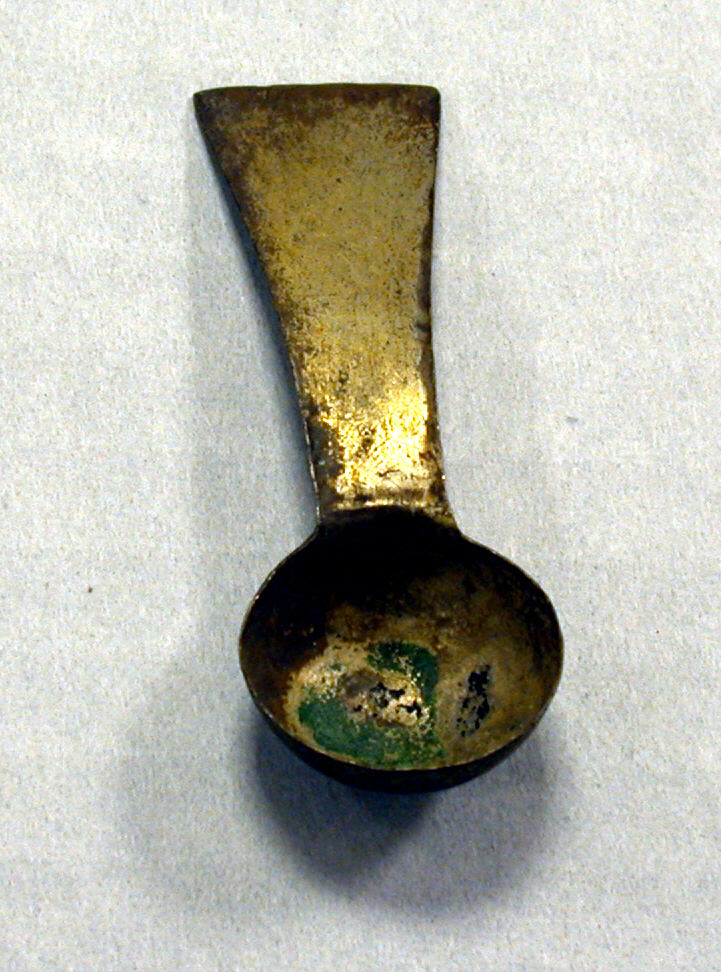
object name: spoon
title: Hammered Silver Spoon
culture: peruvian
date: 701-1566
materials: gilt, silver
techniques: hammering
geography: peru